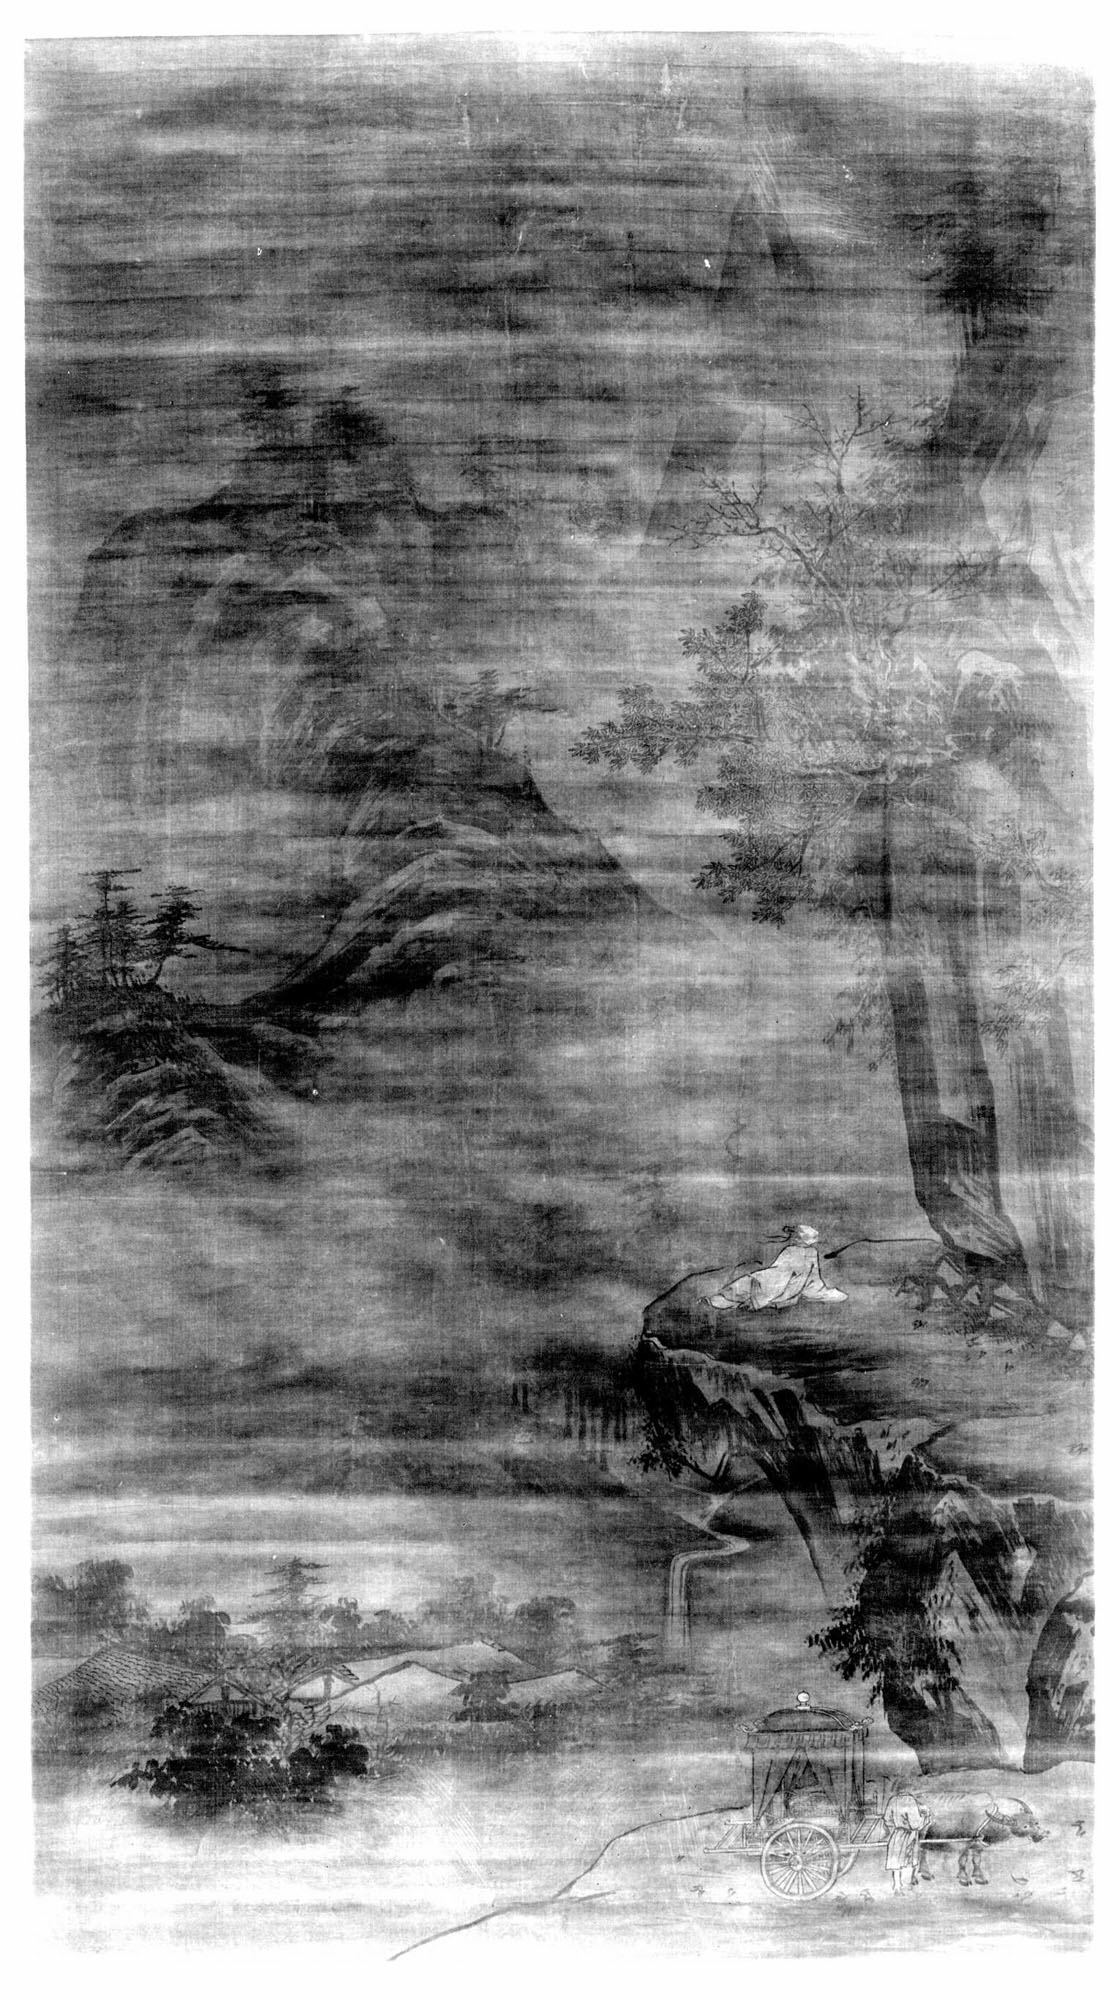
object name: hanging scroll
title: Scholar Admiring Autumn Scenery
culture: chinese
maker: unidentified artist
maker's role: artist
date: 1467-1533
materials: ink, silk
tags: landscapes